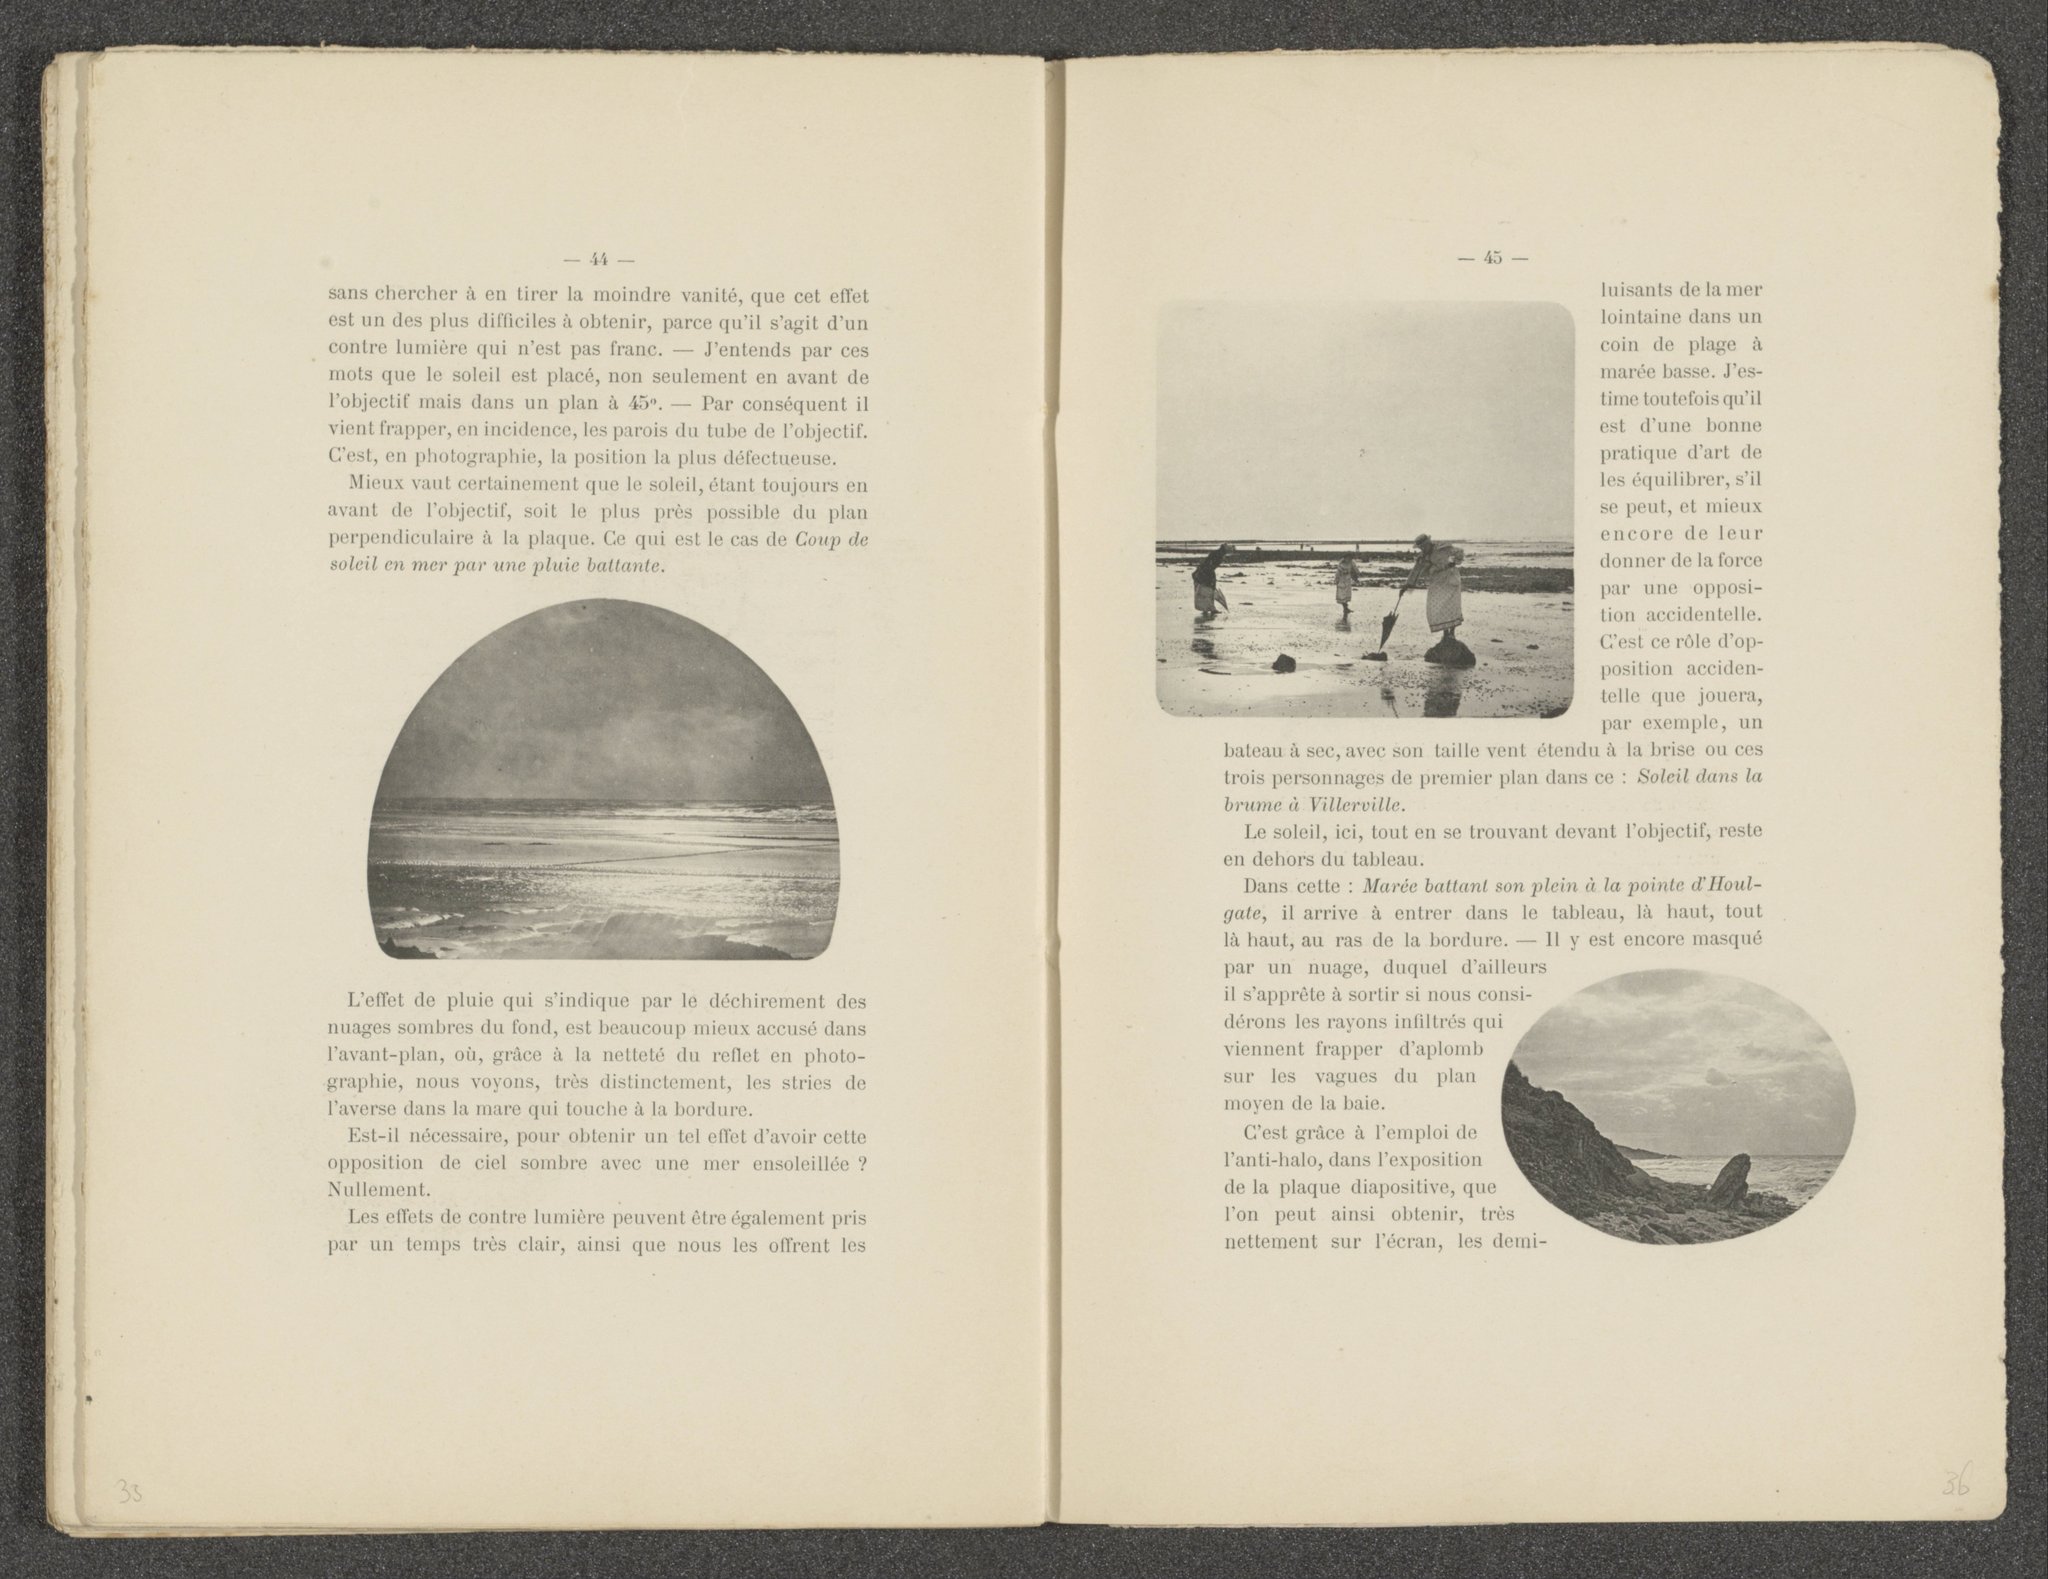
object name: photomechanical print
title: Drie vrouwen op een strand en een gezicht op een rotsachtige kust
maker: Anonymous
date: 1886-1896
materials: paper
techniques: photograph, printing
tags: beach (as place of recreation), rocky coast